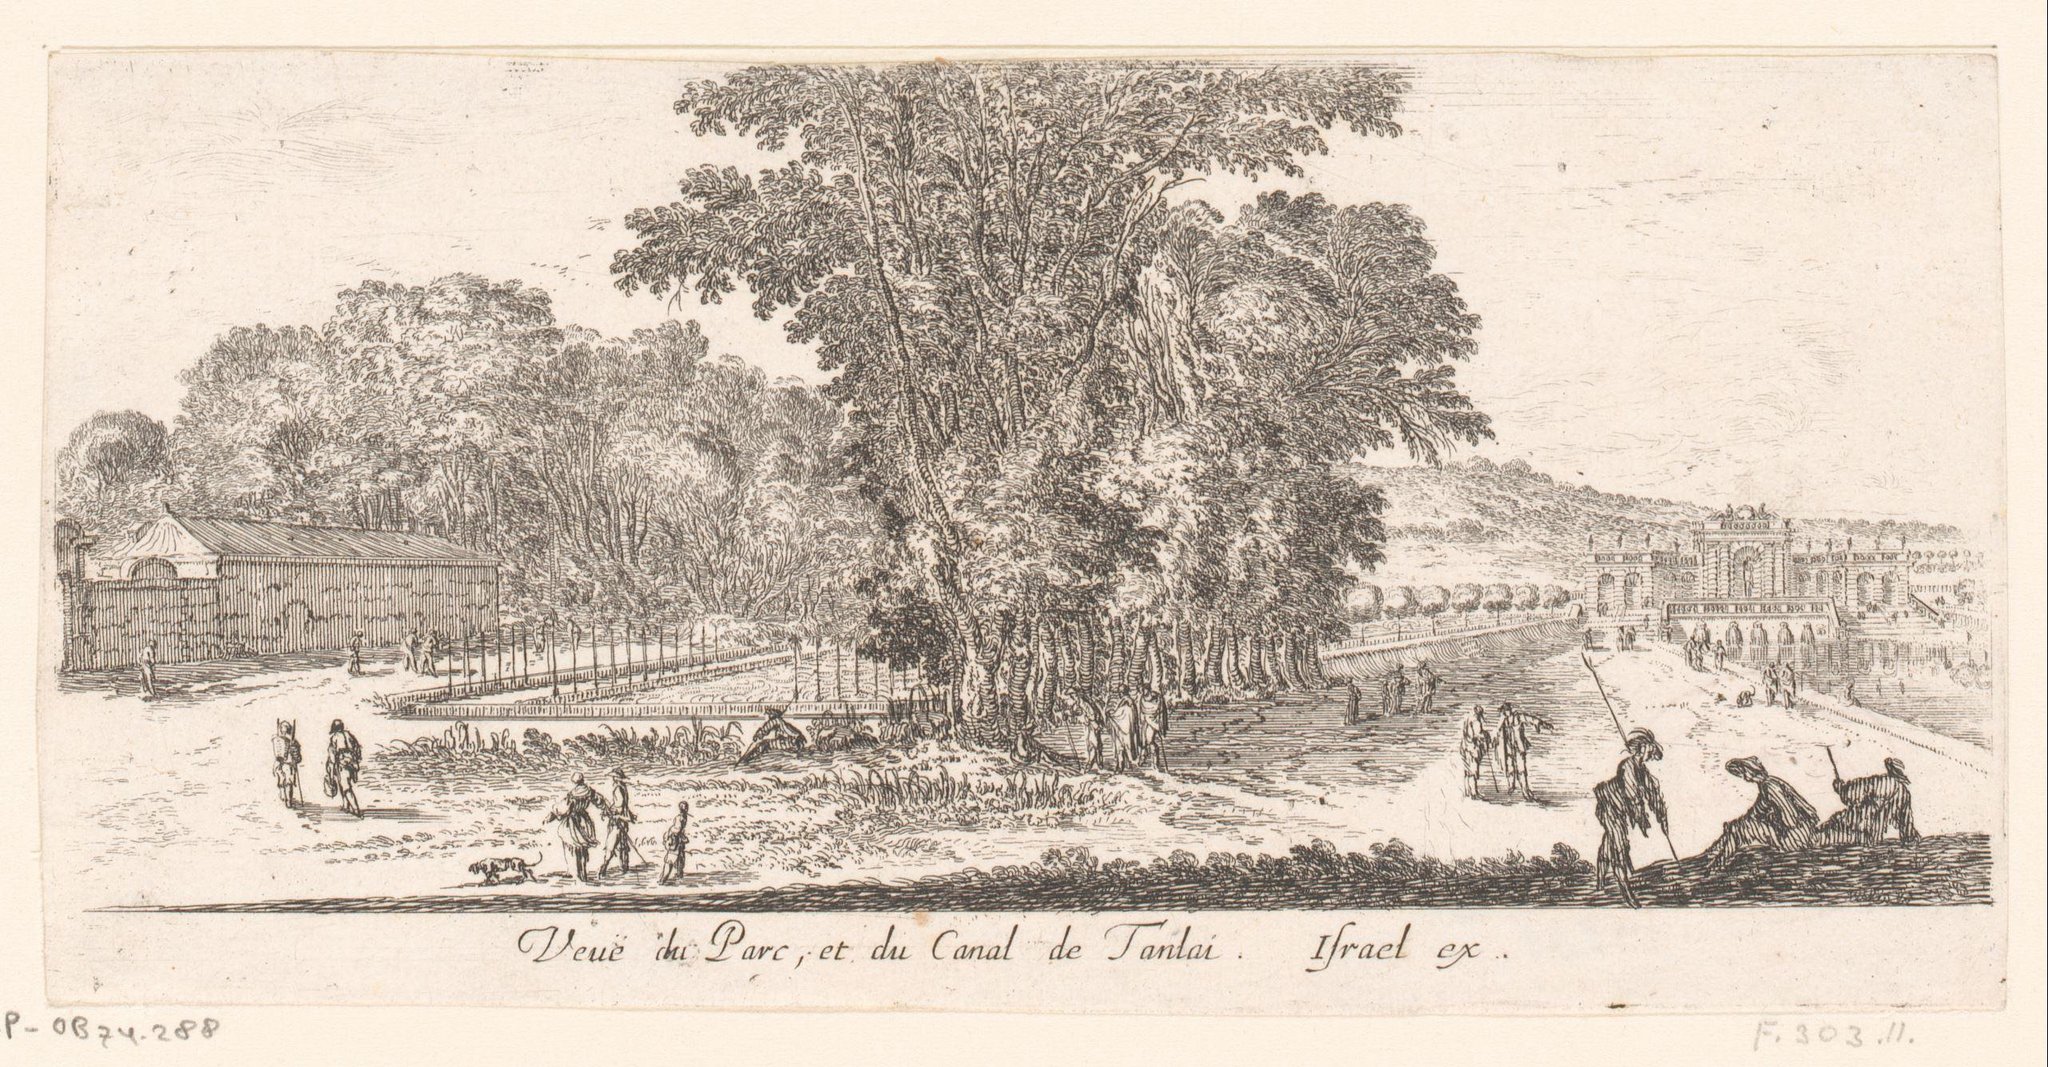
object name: print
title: Veue du Parc et du Canal de Tanlai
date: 1631-1661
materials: paper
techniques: etching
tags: city-view, and landscape with man-made constructions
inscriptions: collector's mark: Lugt 240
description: Prent maakt deel uit van een ongenummerde serie van negen prenten.